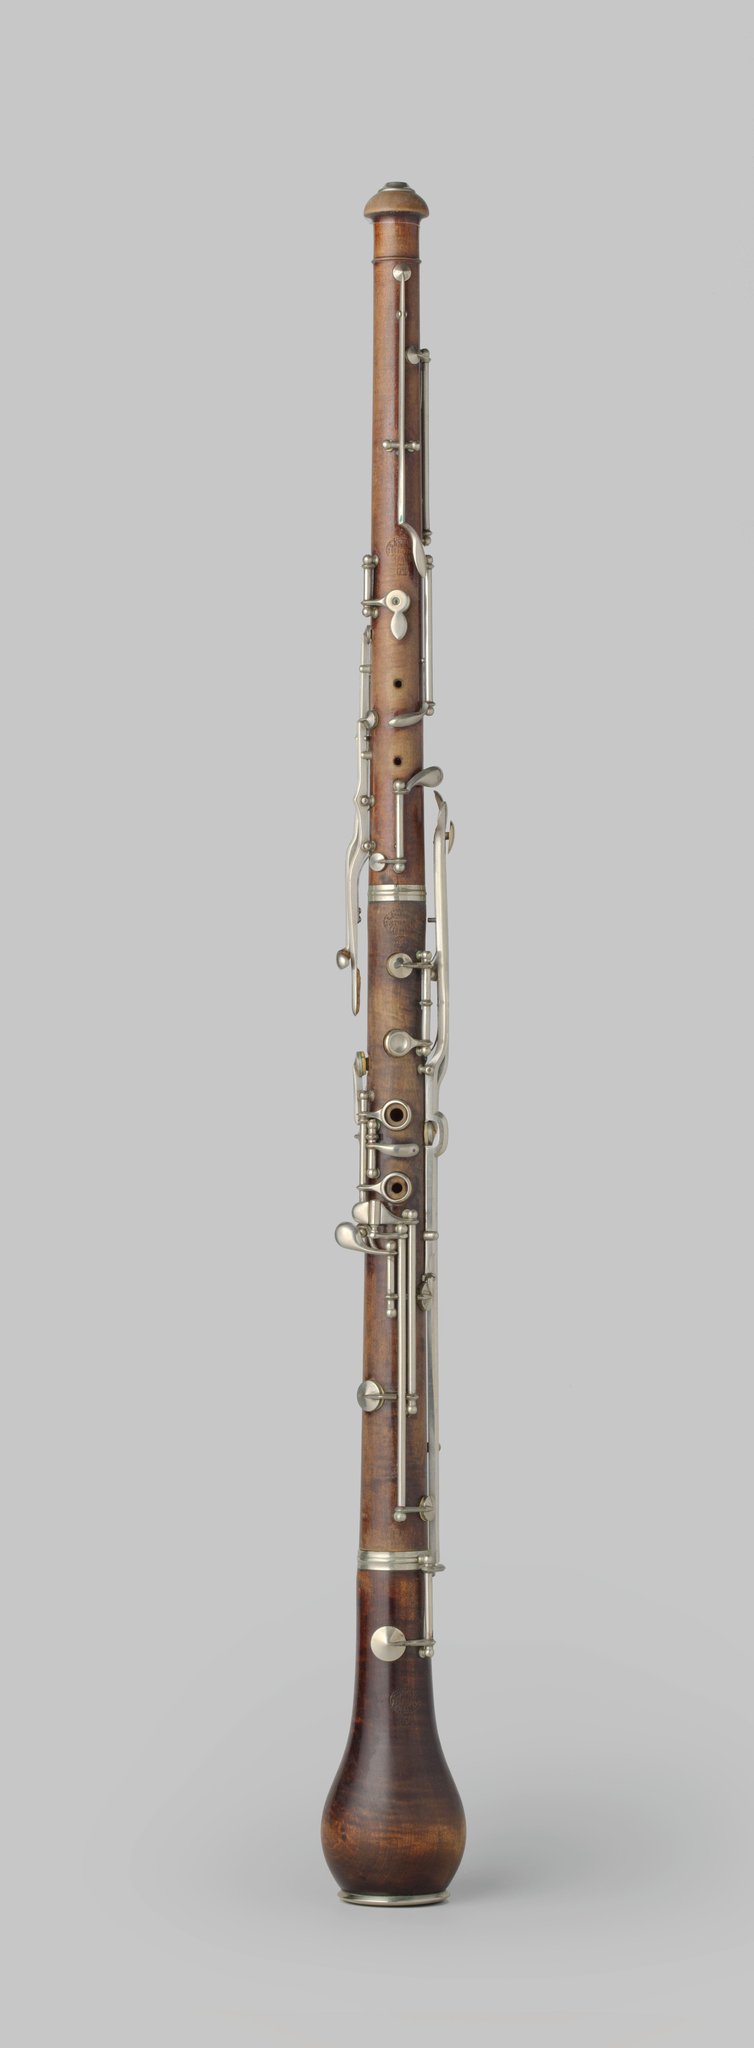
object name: oboe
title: English horn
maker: carlo gherardi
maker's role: musical instrument maker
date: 1850-1899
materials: wood, silver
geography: ferrara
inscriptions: inscription: ‘CARLO GHERARDI / SUCCESSORE AI F[RATE]LLI RIVA / FERRARA’, inscription: ‘[ster] / G. GHERARDI / SUCC[ESSO]RE RIVA / FERRARA (in een ovaal) / RG [monogram]’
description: Engelse hoorn van palmhout met veertien zilveren kleppen, twee open ringen en een vingersteun met een ring voor een koord. Gemarkeerd op alle delen: [ster] / G. GHERARDI / SUCC[ESSO]RE RIVA / FERRARA (in een ovaal) / RG [monogram]. De hobo zit in een houten koffertje bekleed met leer en paars fluweel. Gemarkeerd op de deksel: CARLO GHERARDI / SUCCESSORE AI F[RATE]LLI RIVA / FERRARA. In het koffertje zitten twee mondstukken, een ebbenhouten doosje met wax en een pallisander deksel voor de tap van het bovenste deel. In een vakje in de koffer zitten een gebroken zilveren klep en vier rieten.